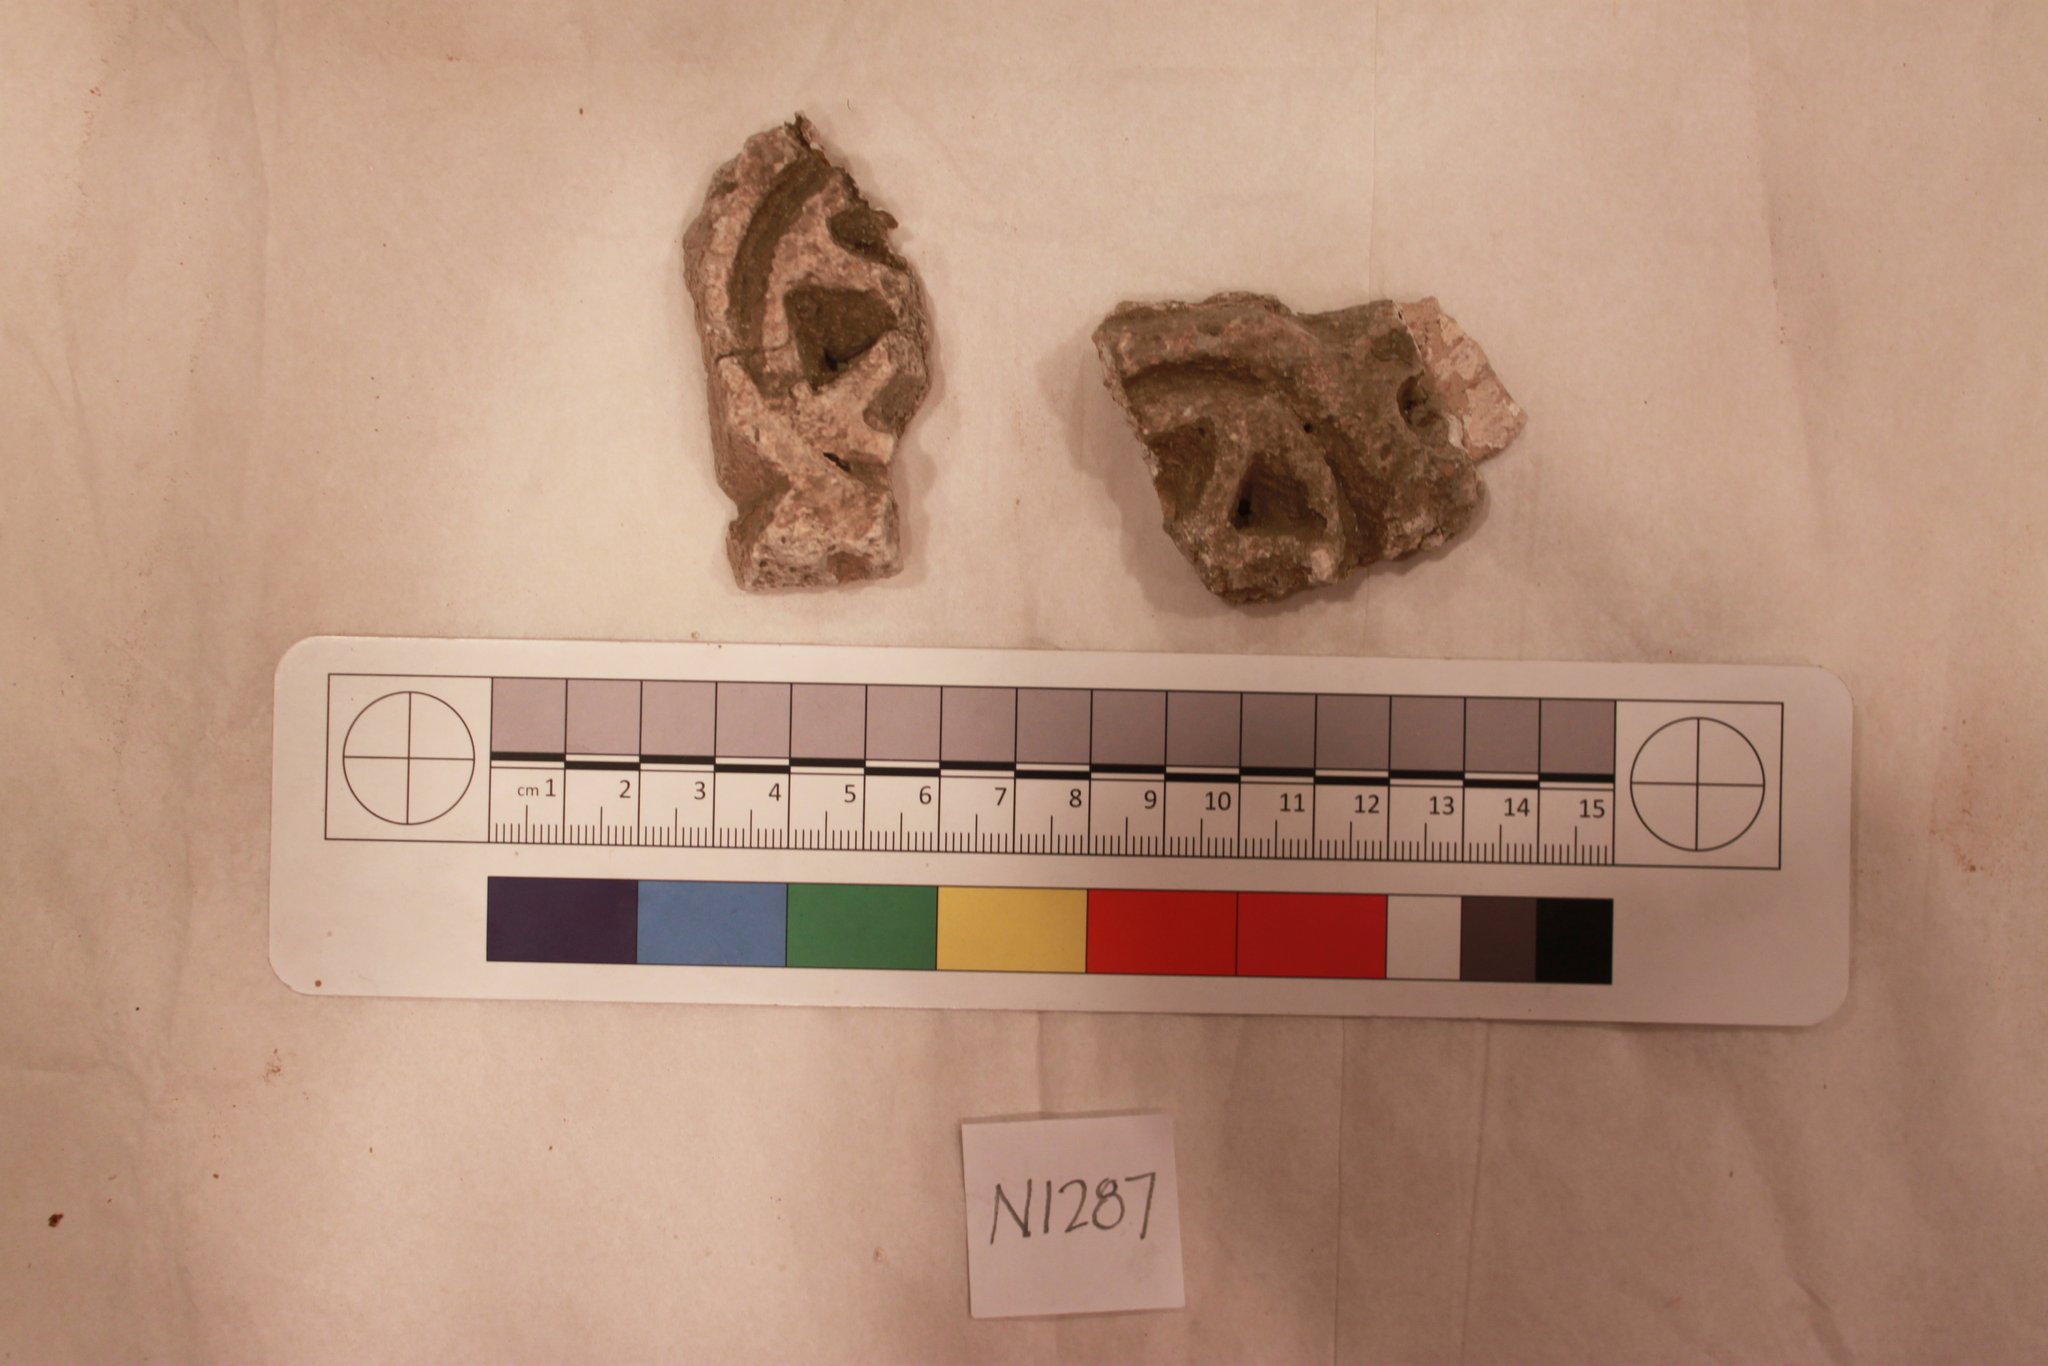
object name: fragment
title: Stucco Fragment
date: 701-1200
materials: plaster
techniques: carving, painting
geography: iran